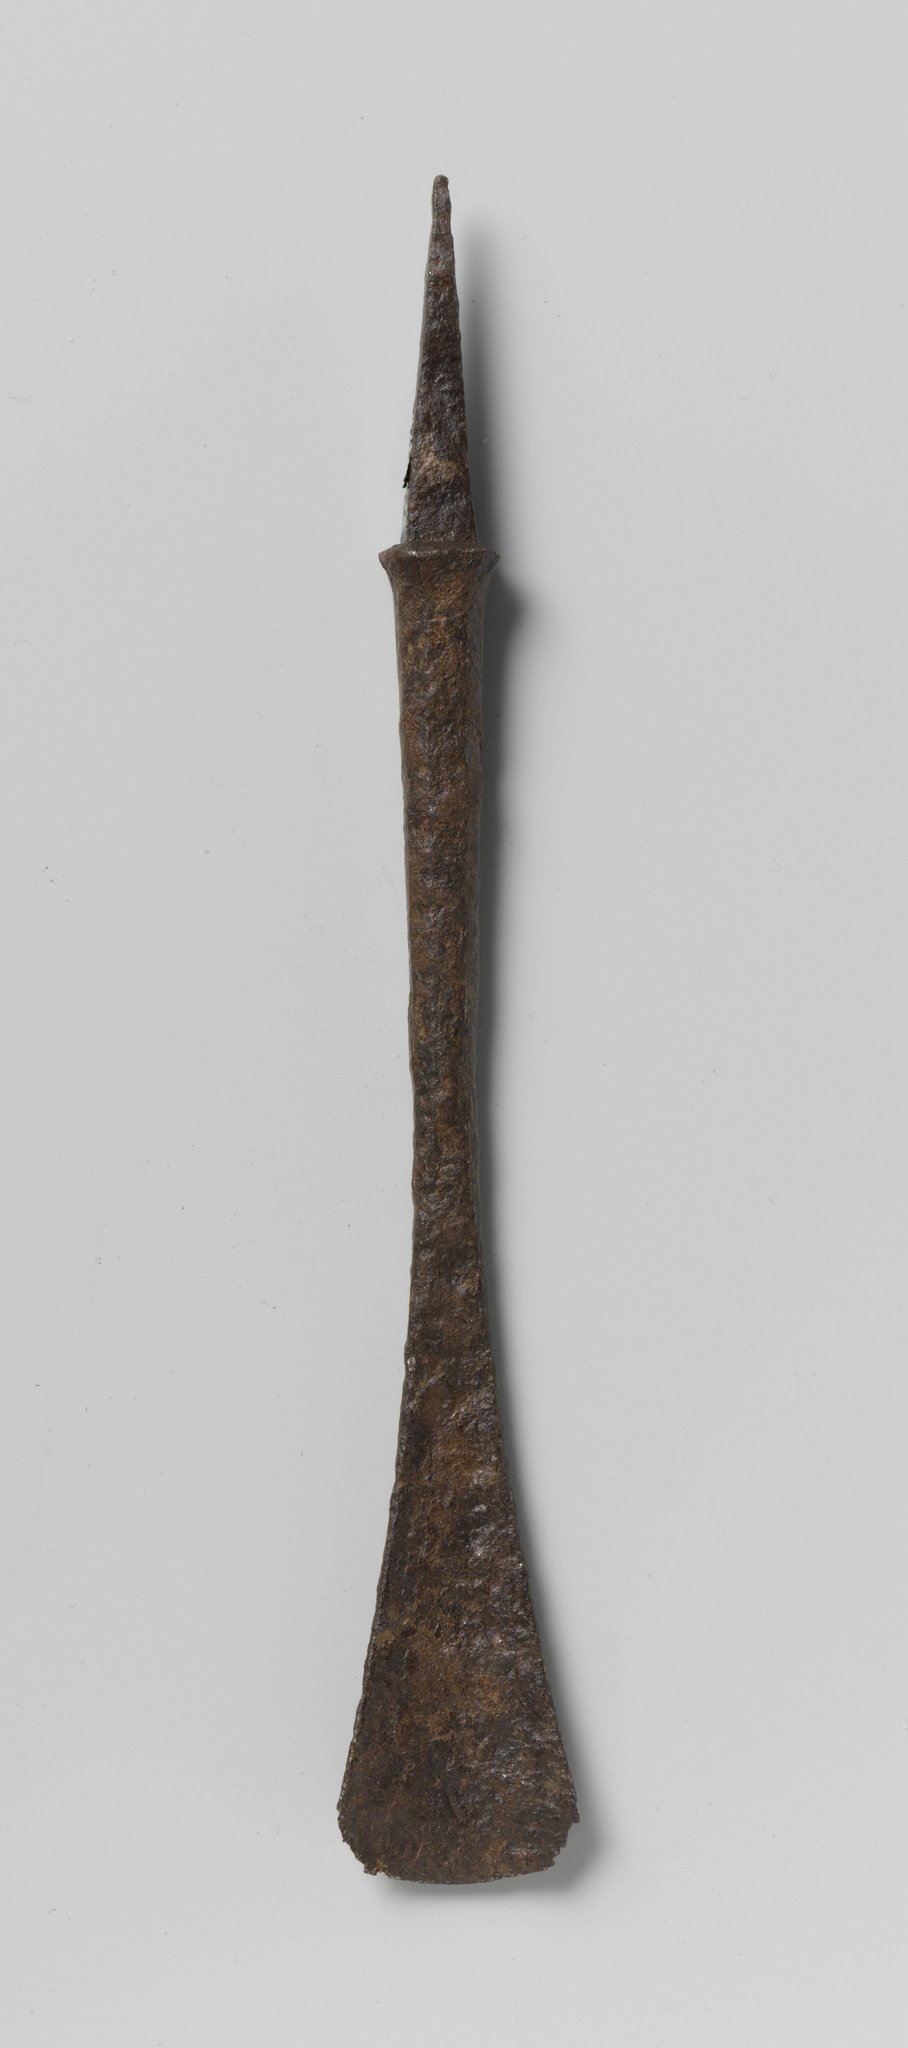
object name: gouge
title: Guts of holle steekbeitel met schuin uitlopende snede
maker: Anonymous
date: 1590-1596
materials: iron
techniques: forging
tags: willem barendsz., amsterdam, jacob van heemskerck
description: Guts of holle steekbeitel met schuin uitlopende snede. Het bijbehorende handvat van hout ontbreekt.